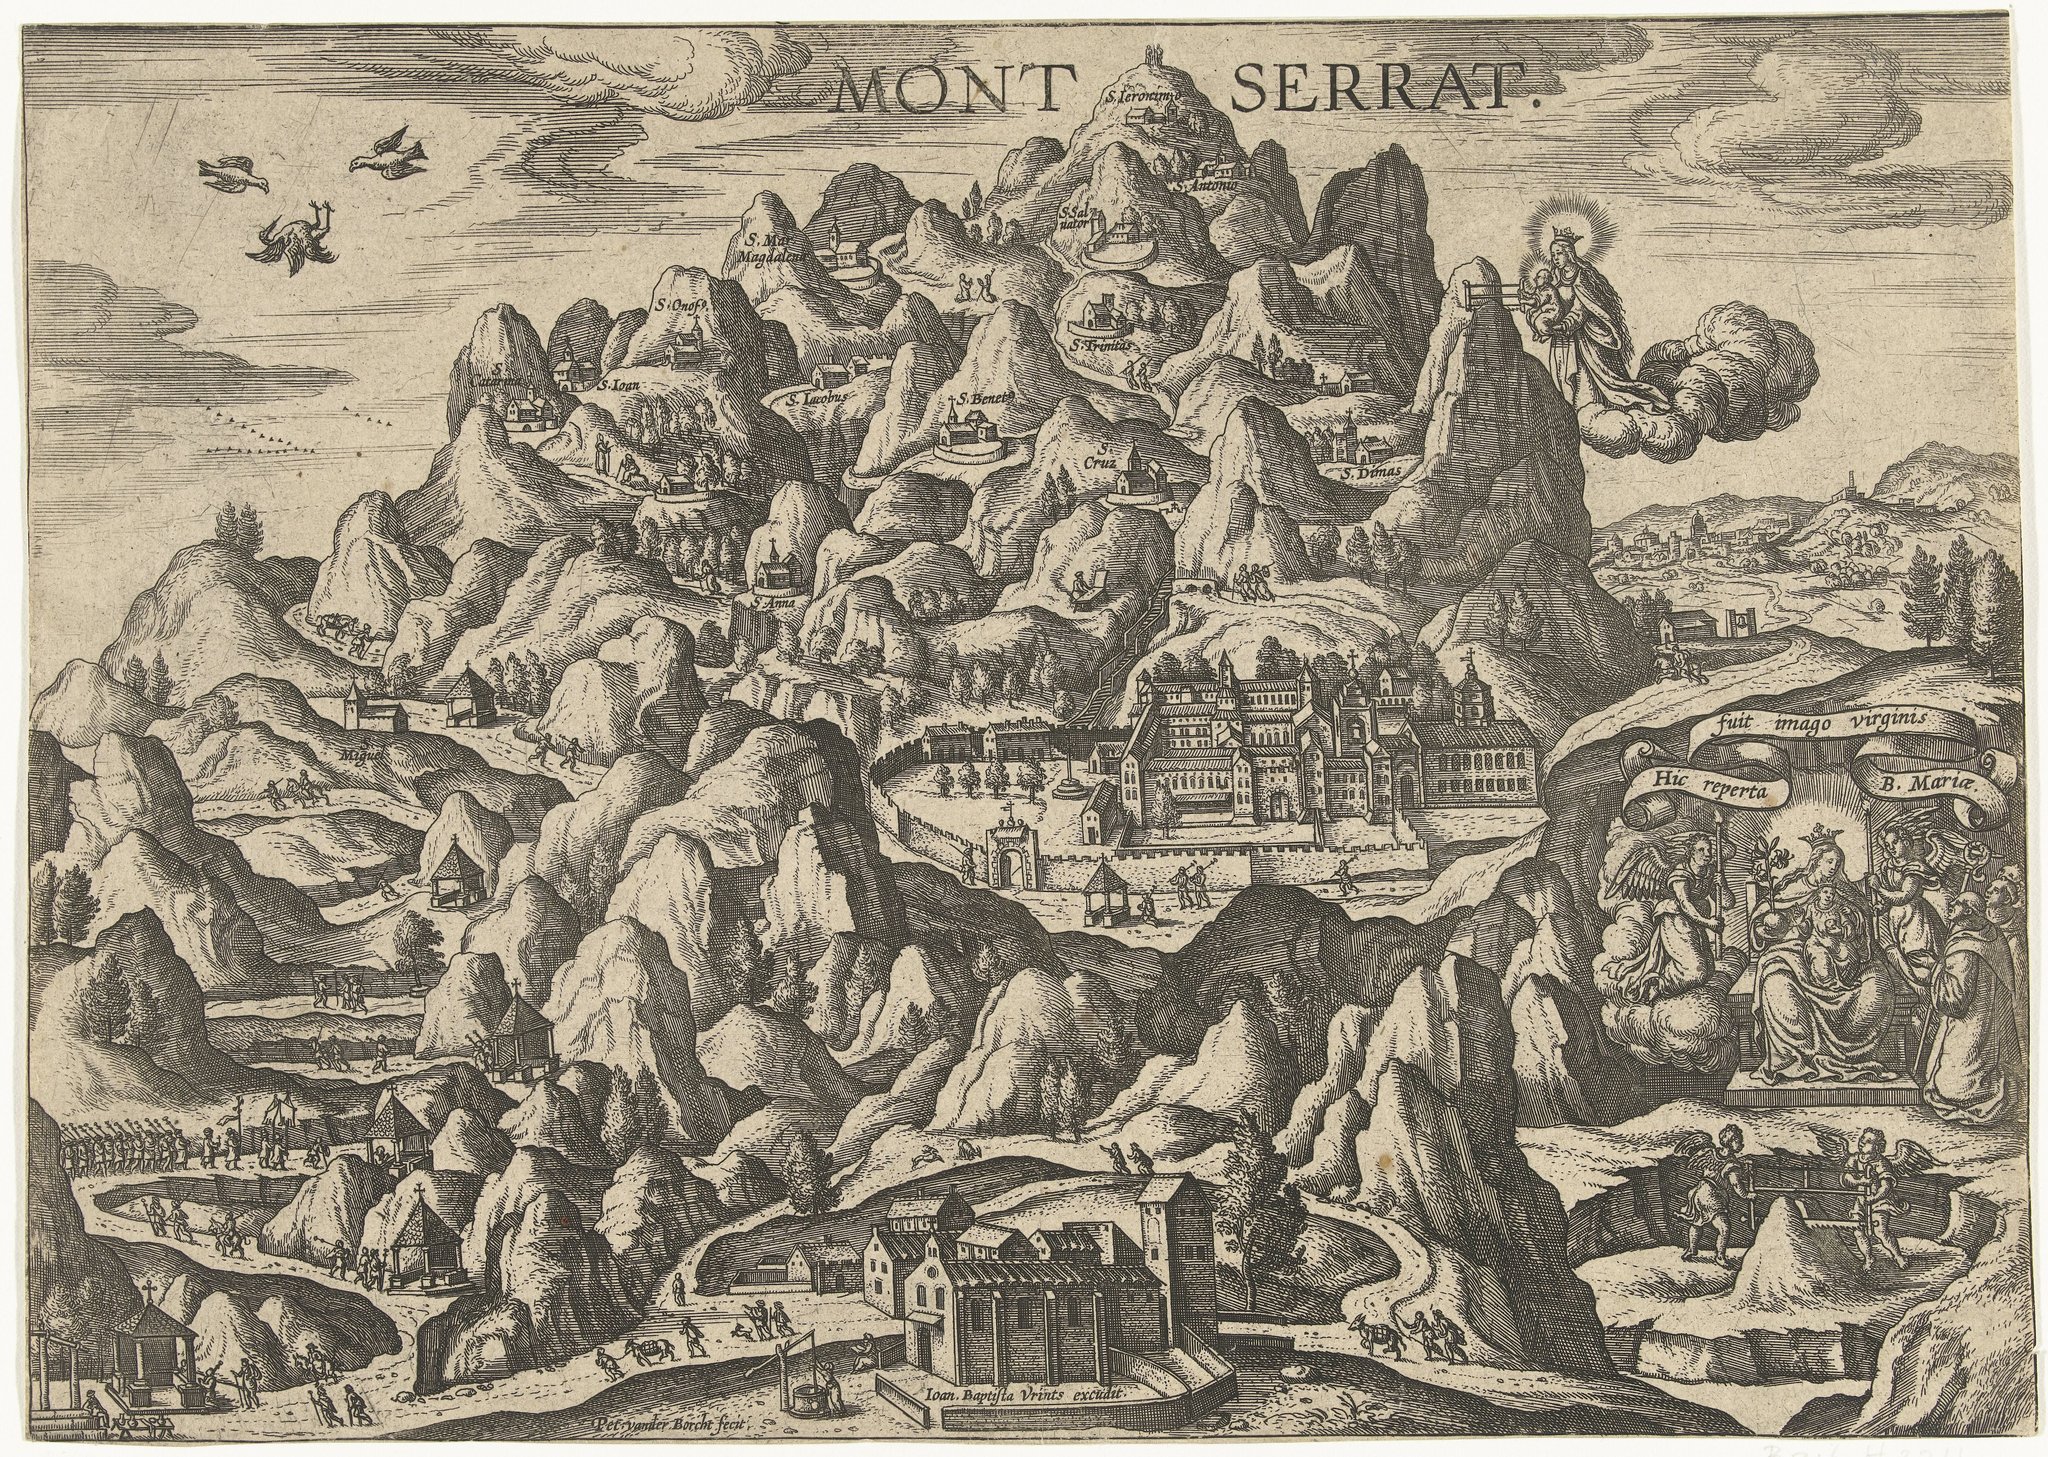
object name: print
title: Montserrat, pelgrimsplaats voor H. Maagd.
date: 1545-1608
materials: paper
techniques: etching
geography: antwerp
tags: madonna (i.e. mary with the christ-child) accompanied or surrounded by others, madonna (i.e. mary with the christ-child) in the air, or on the clouds, pilgrimage, pilgrim(s) under way, angels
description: De berg Montserrat in Catelonië (Spanje) met omringende kloosters en kerken (met namen). Centraal staat Santa Maria de Montserrat, het benedictijnenklooster. Aan de linkerkant een beginnende pelgrimage. Aan de rechterzijde de locale grot Santa Cova, met de verschijning van de H. Maagd (en kind). Aan elke zijde van haar een engel met een kaars. Drie geestelijken knielen in aanbidding voor Maria neer. Op de rechtervoorgrond twee engeltjes die een steen doorzagen. Op de rechterachtergrond zaagt de H. Maagd een rots door. Beide figuren verwijzen naar de origine van de naam Montserrat [gezaagde berg].